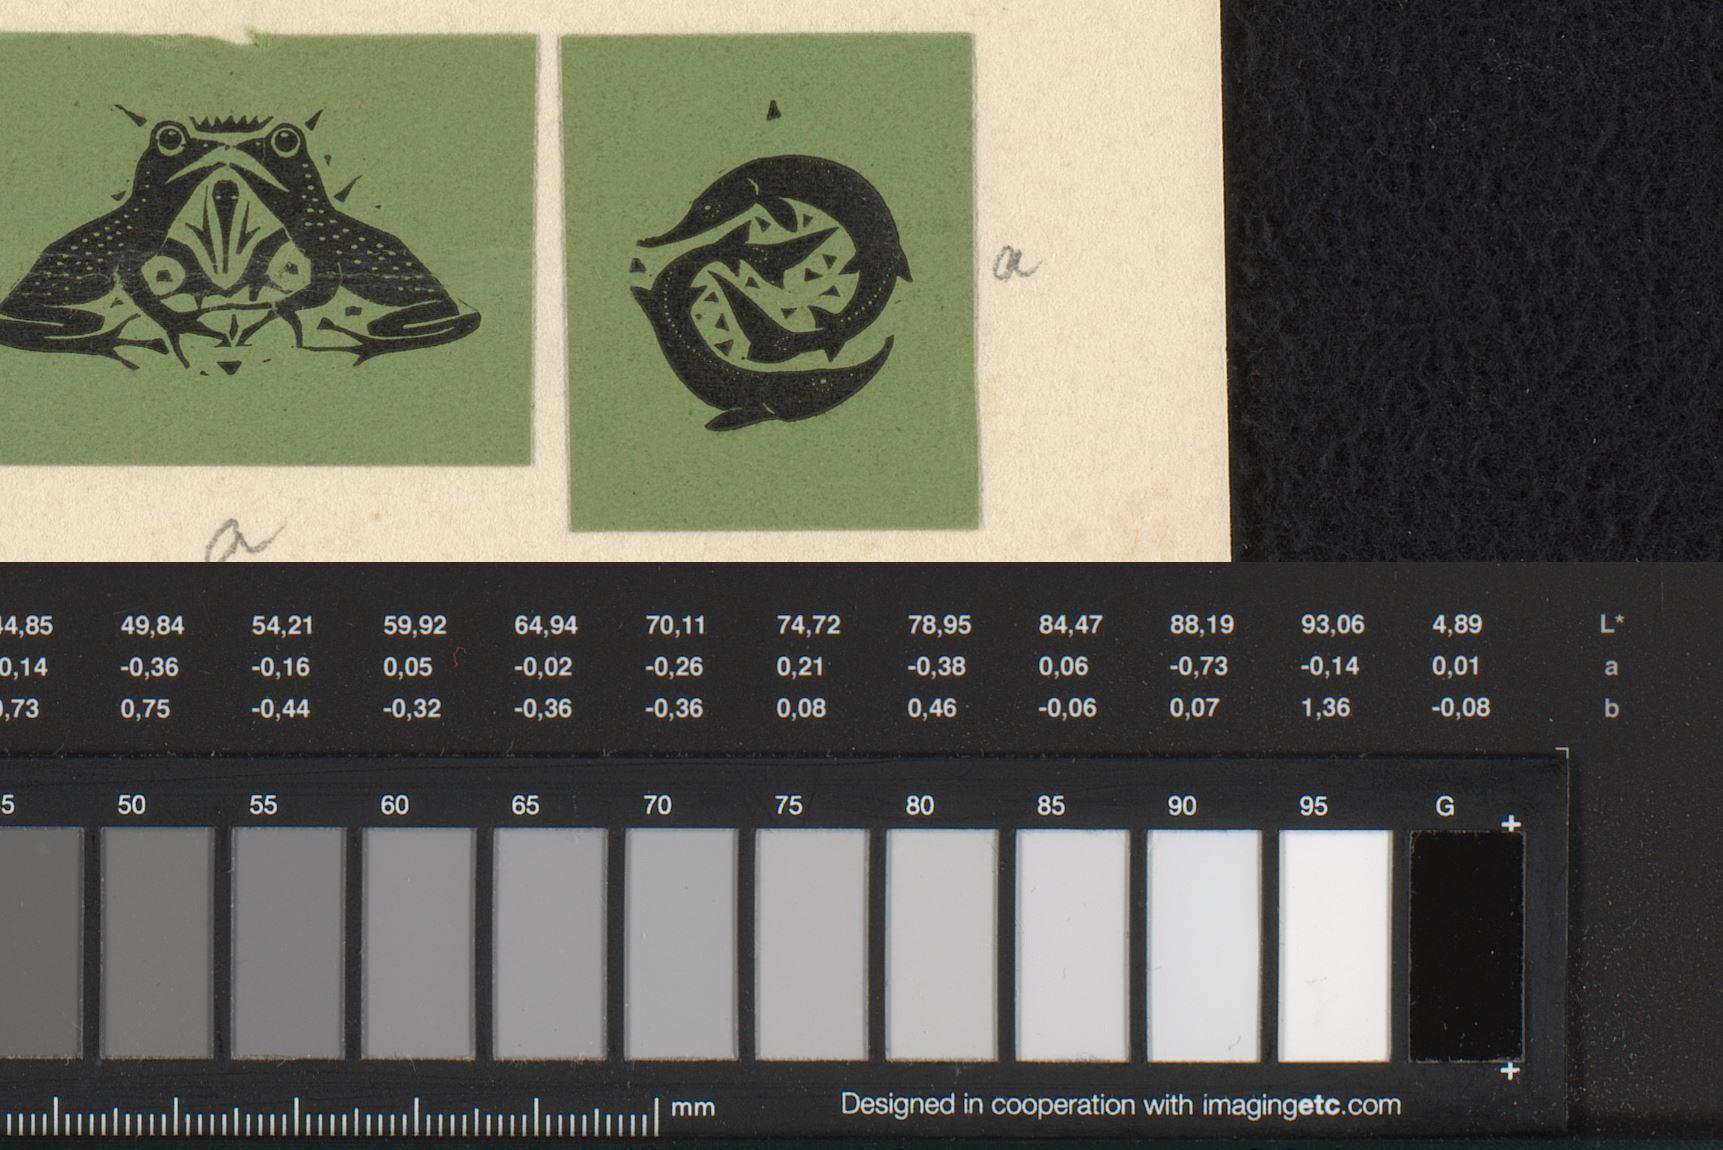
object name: book illustration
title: Sluitvignet met twee steuren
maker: gerrit willem dijsselhof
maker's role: designer, draughtsman, print maker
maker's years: 1866-1924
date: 1893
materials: paper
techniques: galvanoplasty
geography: amsterdam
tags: bony fishes: sturgeon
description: Sluitvignet gebruikt in: Crane, Walter. Kunst en samenleving. [Vertaald uit het Engels door] Jan Veth. Amsterdam: Scheltema & Holkema's Boekhandel, 1894 [1893], p. 157. Later zijn deze afbeeldingen door de uitgever veelvuldig gebruikt voor andere uitgaven. Zie bijvoorbeeld RP-P-1969-415, een catalogus van de in 1894 bij Scheltema & Holkema's Boekhandel verkrijgbare publicaties.